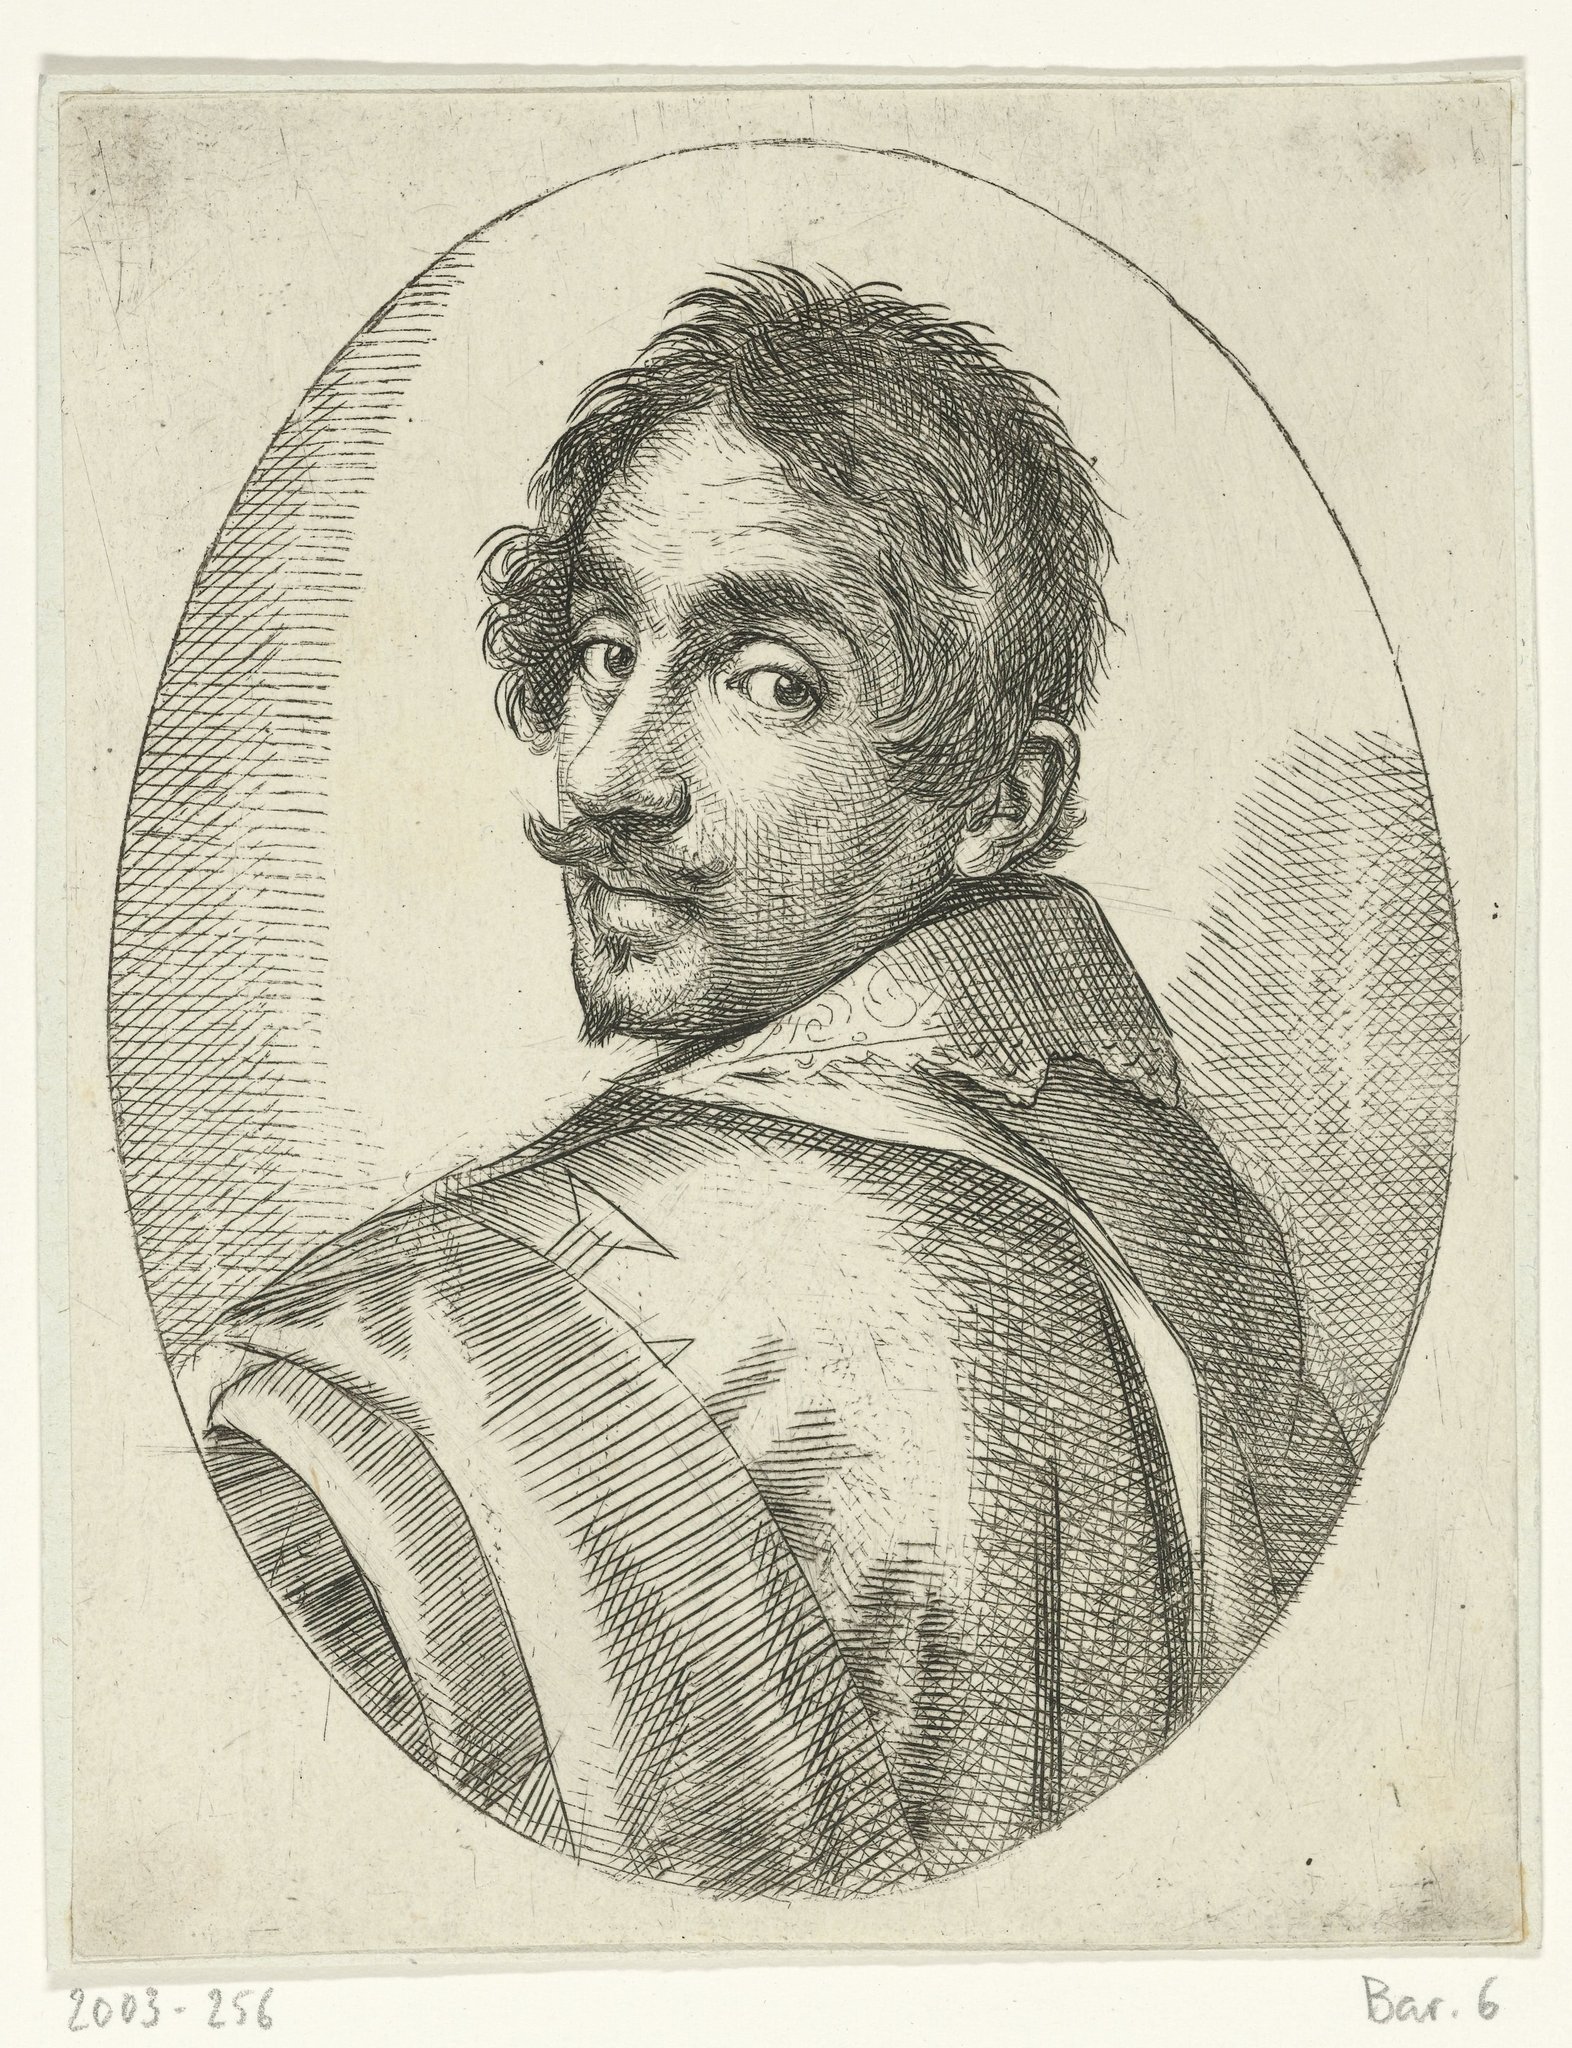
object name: print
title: Zelfportret van Ottavio Leoni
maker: ottavio mario leoni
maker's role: draughtsman, print maker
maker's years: 1578-1630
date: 1598-1630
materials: paper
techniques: engraving, etching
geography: italy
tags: draughtsman, ottavio mario leoni, knighthood order, portrait, self-portrait of artist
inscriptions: collector's mark: Lugt 2228, collector's mark: Lugt 2760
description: Portret van een man, mogelijk een zelfportret van de kunstenaar Ottavio Leoni, over zijn linkerschouder kijkend. Hij draagt een mantel met op de mouw een kruis van de orde van Christus.